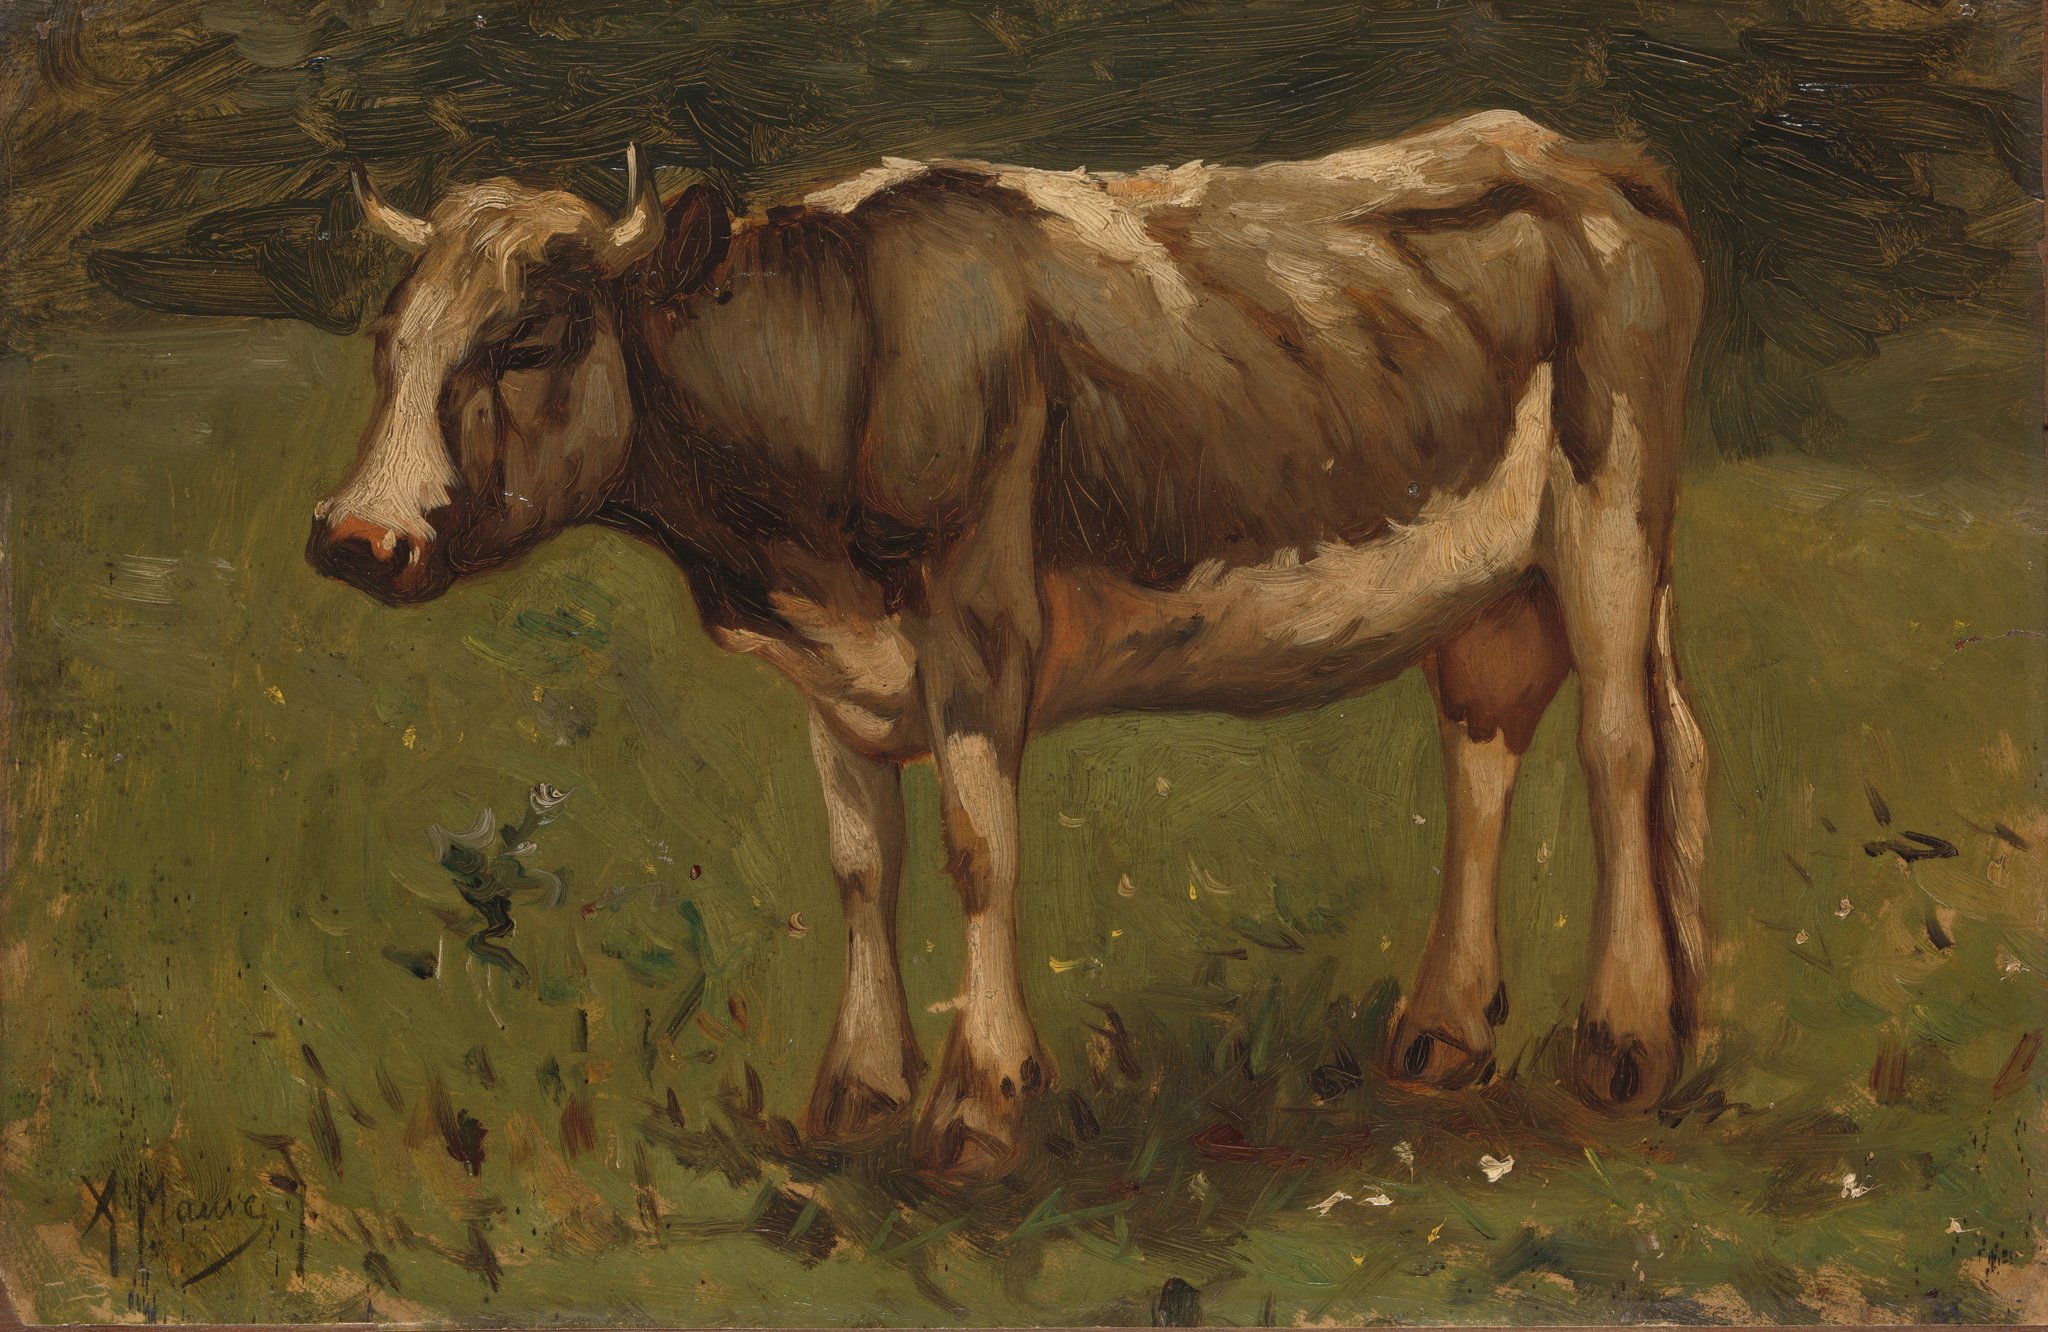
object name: painting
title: Koe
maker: anton mauve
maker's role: draughtsman, painter, print maker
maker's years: 1838-1888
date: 1860-1888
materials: oil, panel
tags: cow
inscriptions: signature: ‘A Mauve’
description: Een staande koe in een weide, naar links.